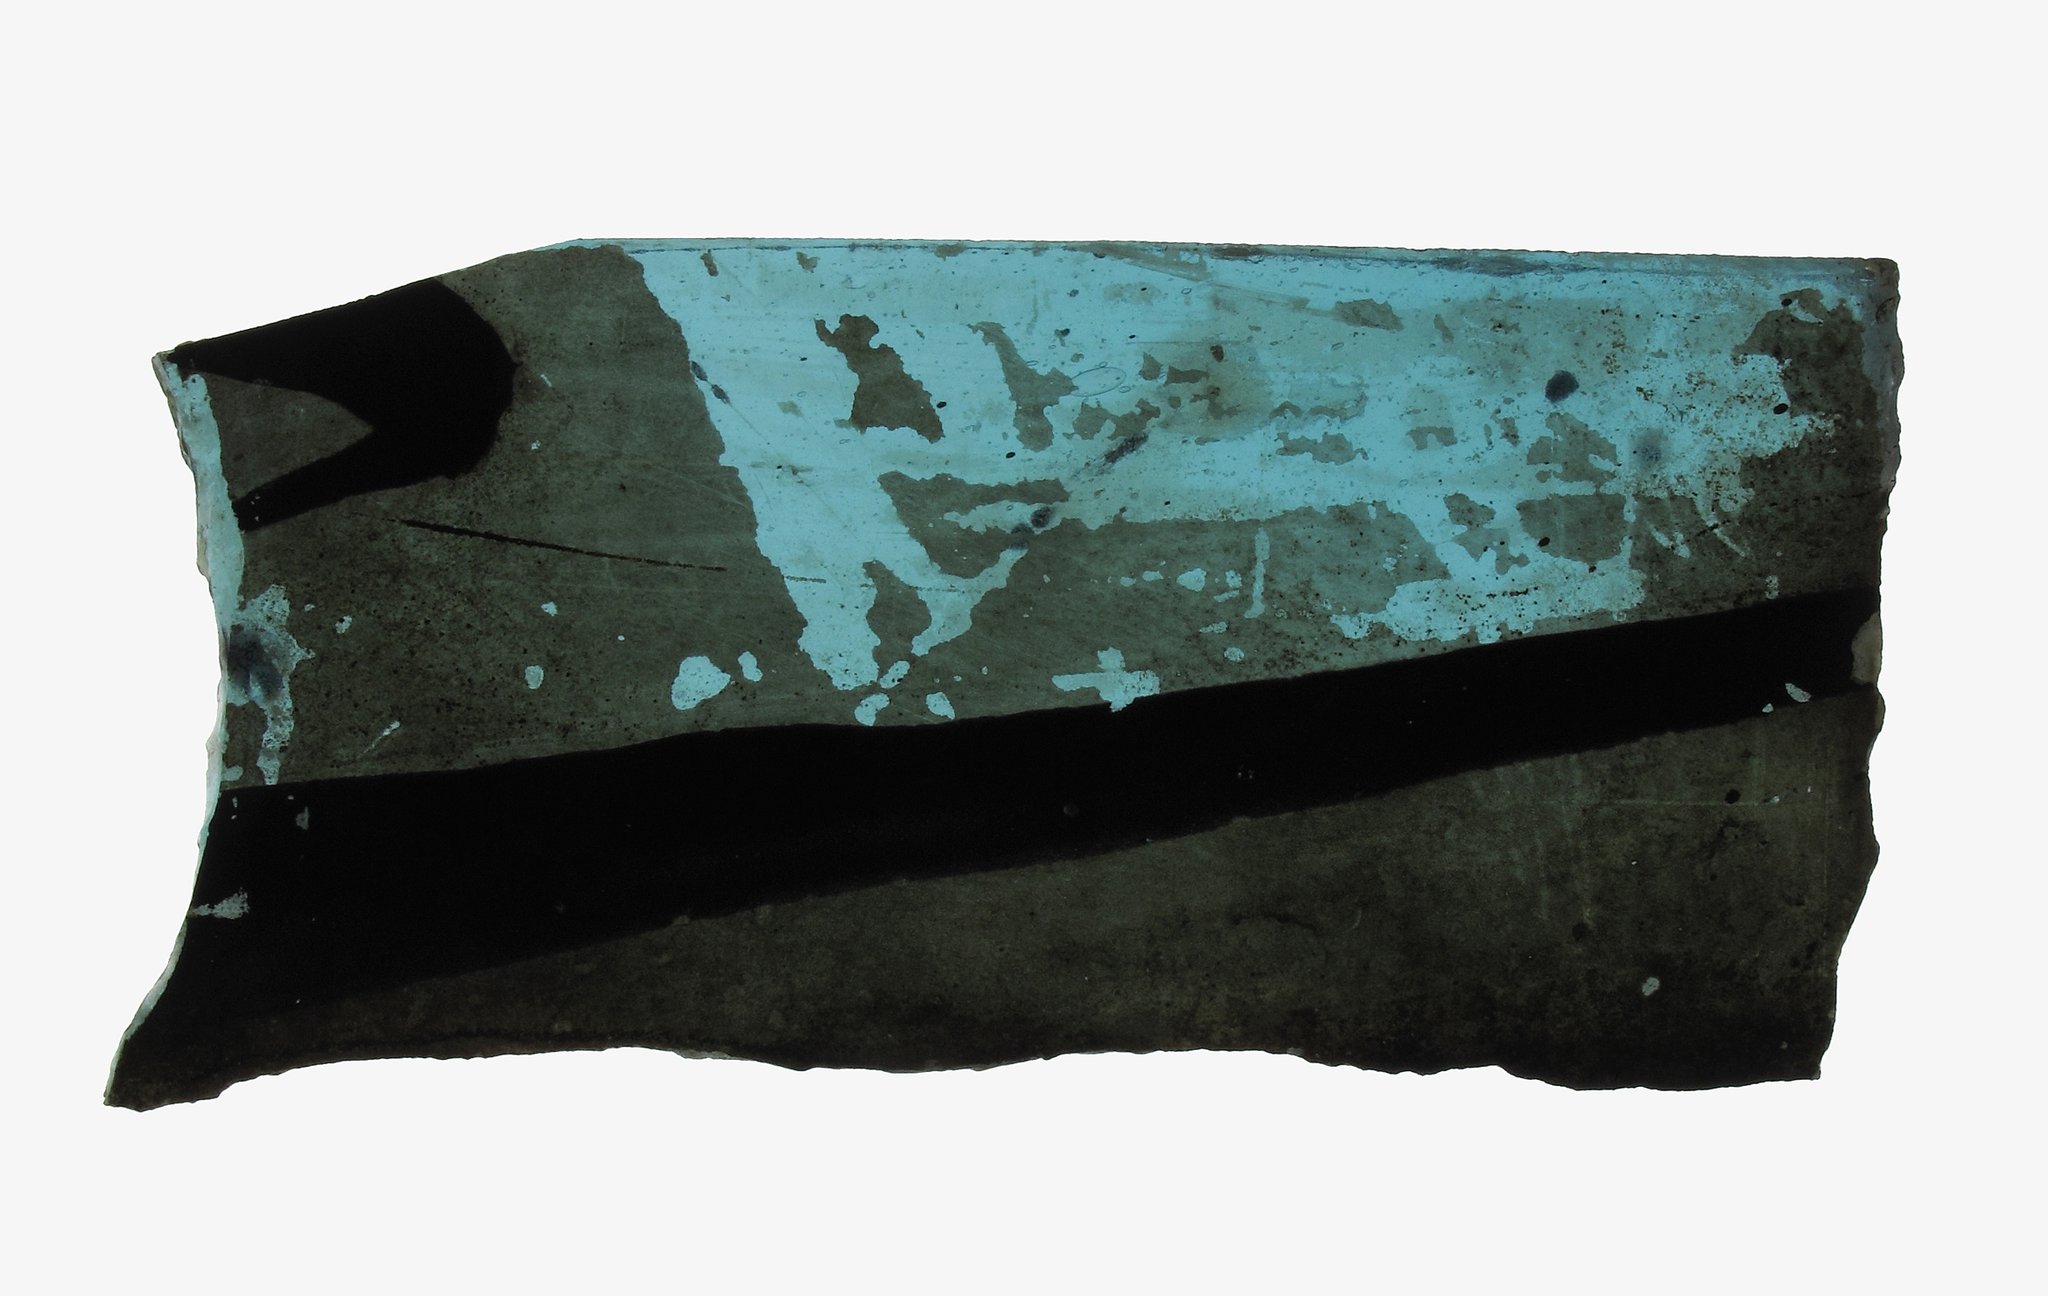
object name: fragment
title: Glass Fragment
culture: european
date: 1101-1700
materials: glass, metal, paint